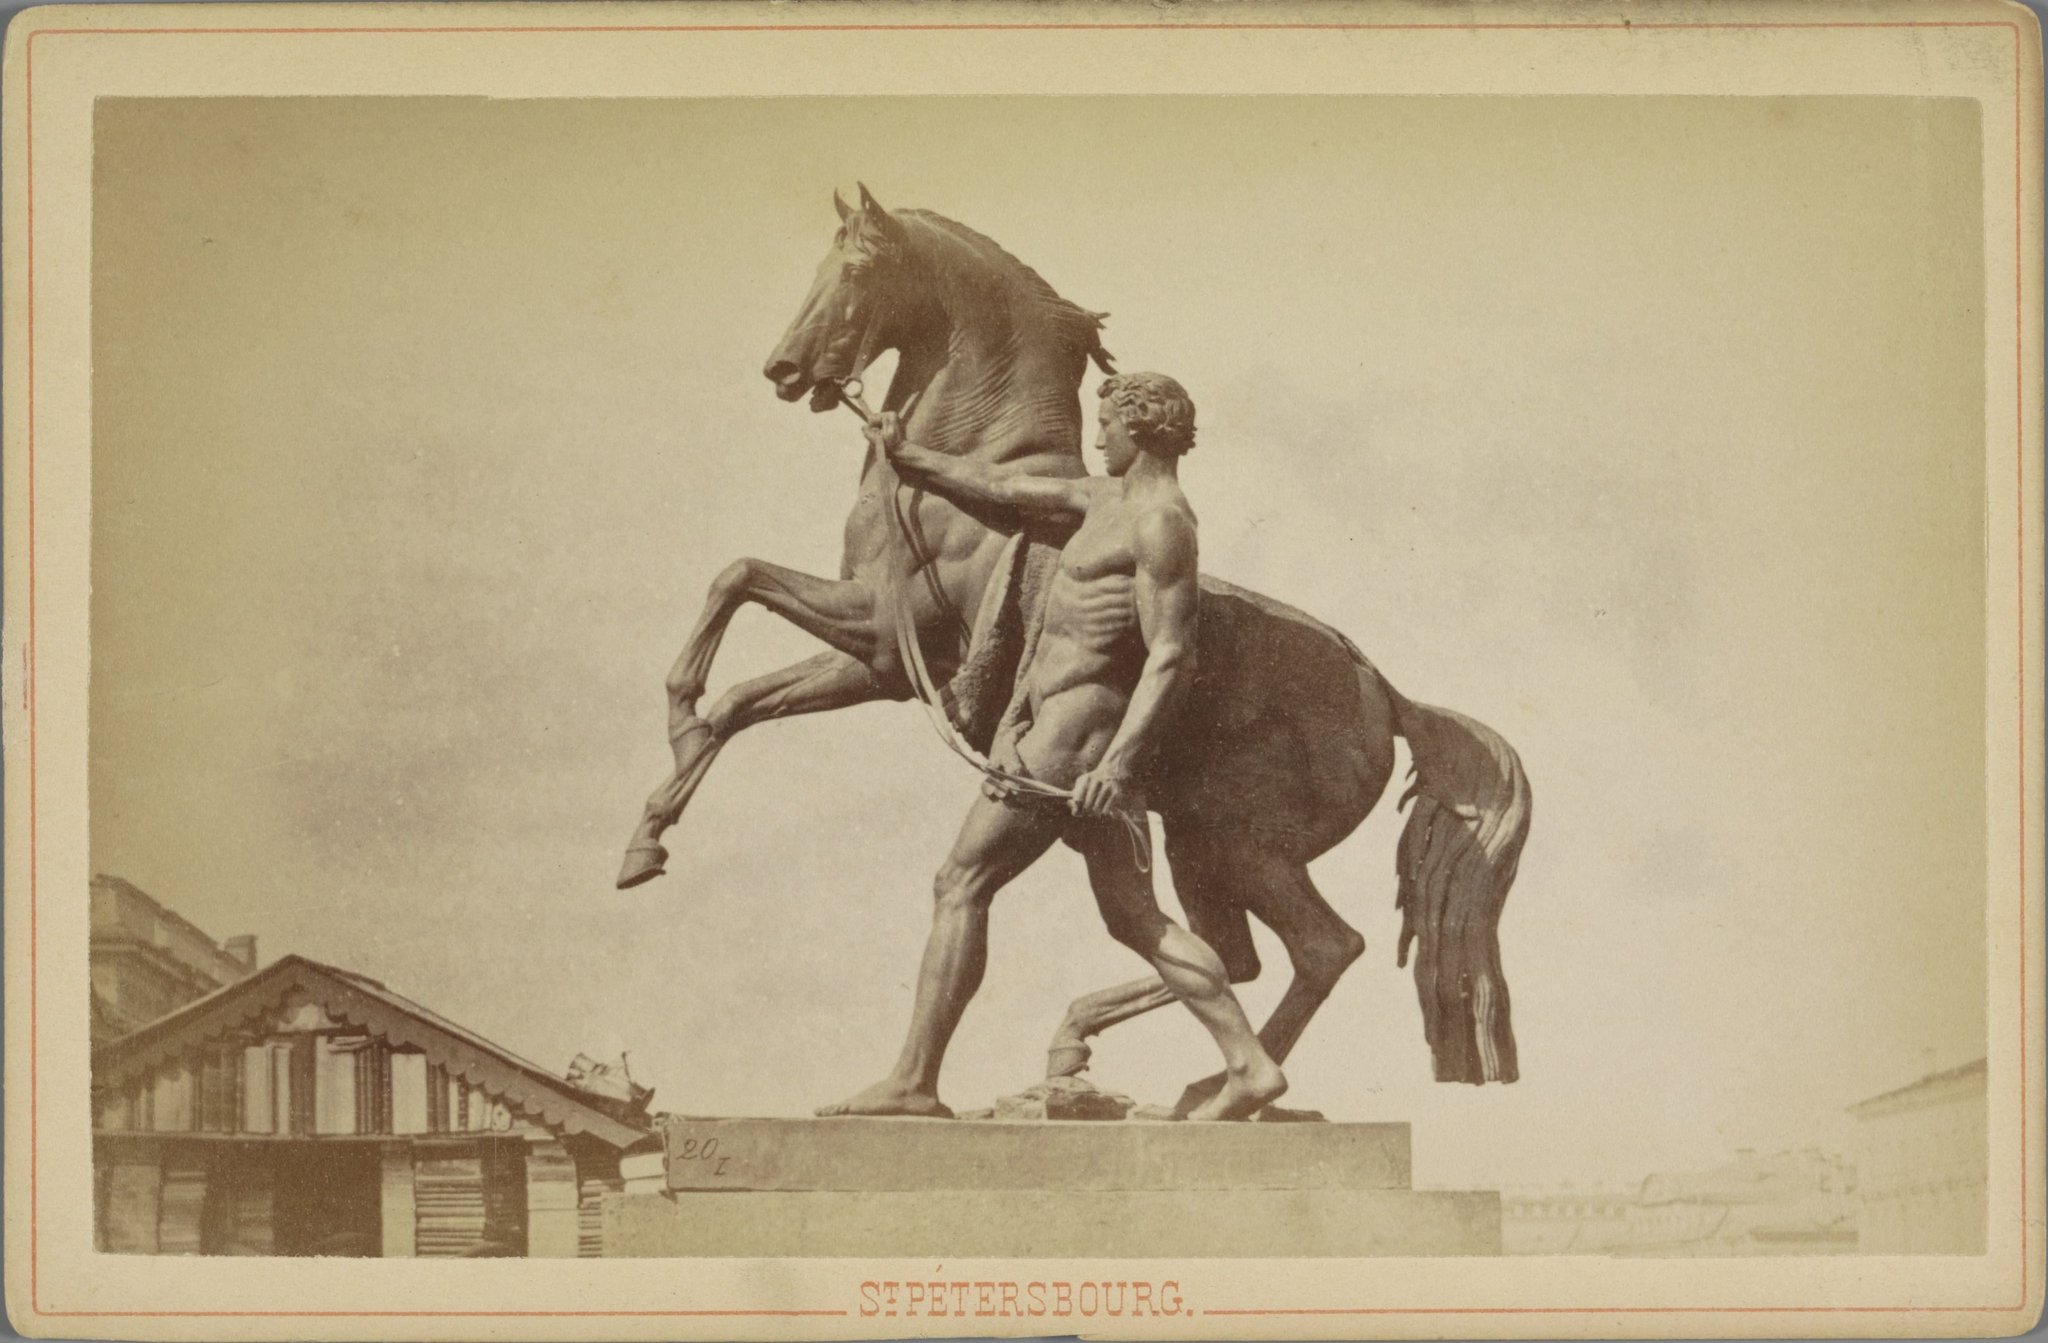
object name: cabinet photograph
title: St. Petersbourg.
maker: joseph daziaro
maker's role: publisher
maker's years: 1831-1892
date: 1880-1900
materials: cardboard, photographic support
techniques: albumen print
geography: sint-petersburg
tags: piece of sculpture, reproduction of a piece of sculpture (+ sculpture), bridge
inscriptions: inscription: ‘Pont Anitschkoff’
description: Onderdeel van Fotoalbum met opnames van Sint-Petersburg.